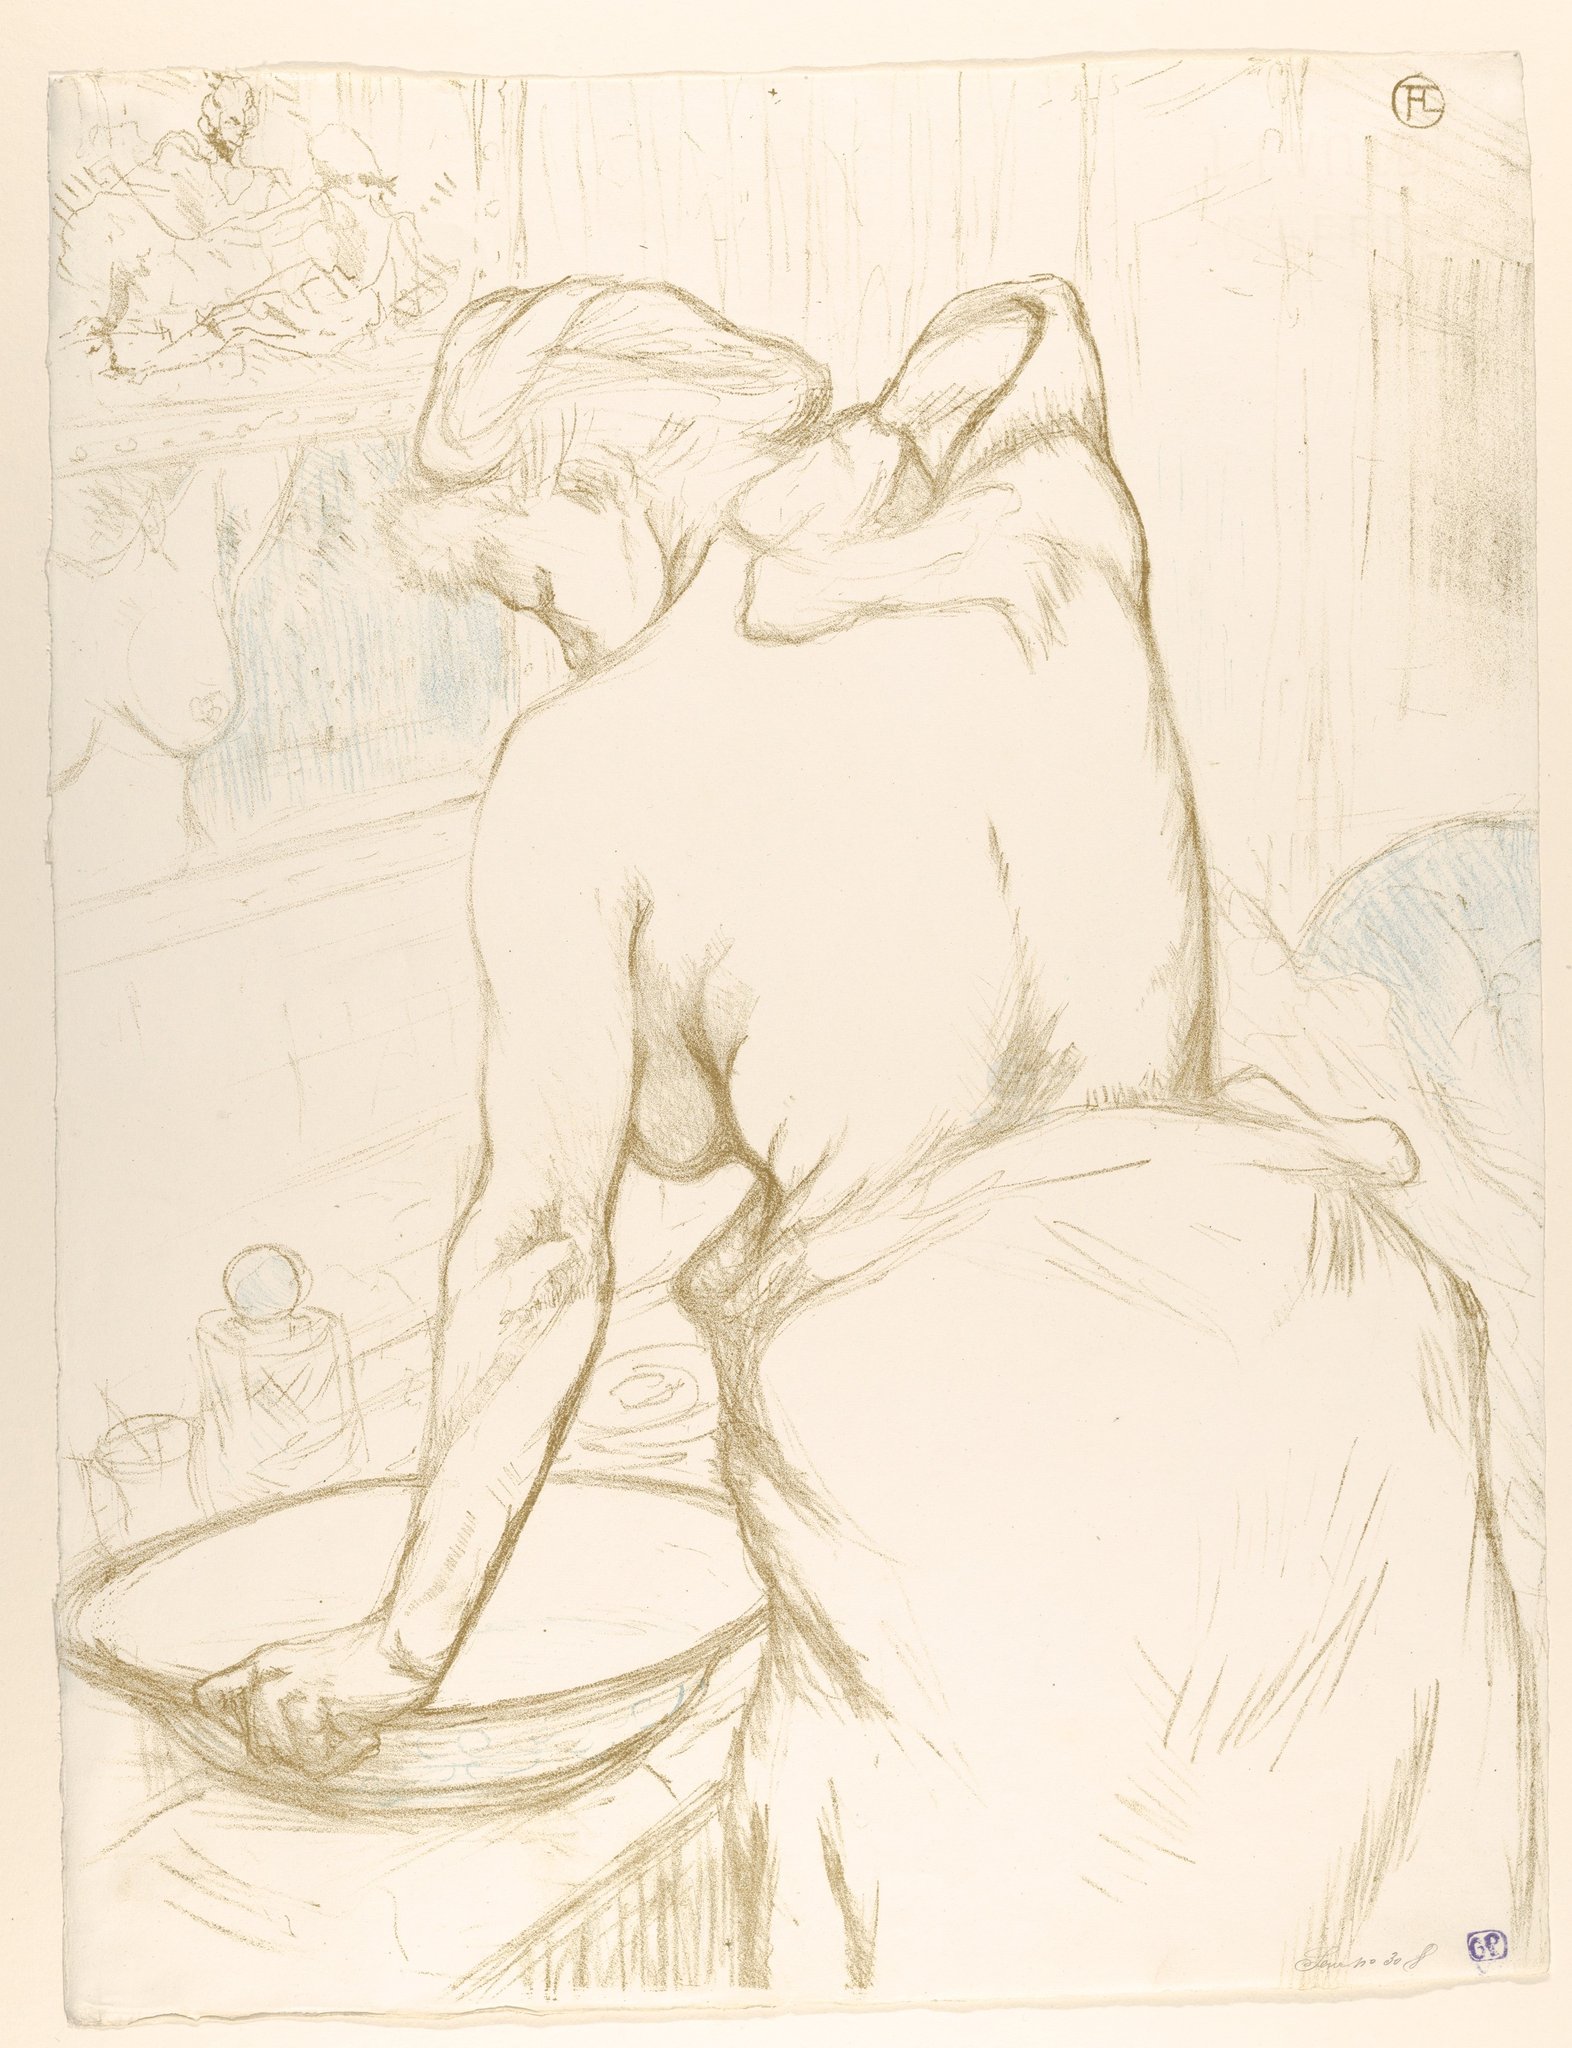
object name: print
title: Washing, from "Elles"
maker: henri de toulouse-lautrec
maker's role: artist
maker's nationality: french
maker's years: 1864-1901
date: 1896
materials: crayon, paper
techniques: lithograph, printing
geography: france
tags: female nudes,washing